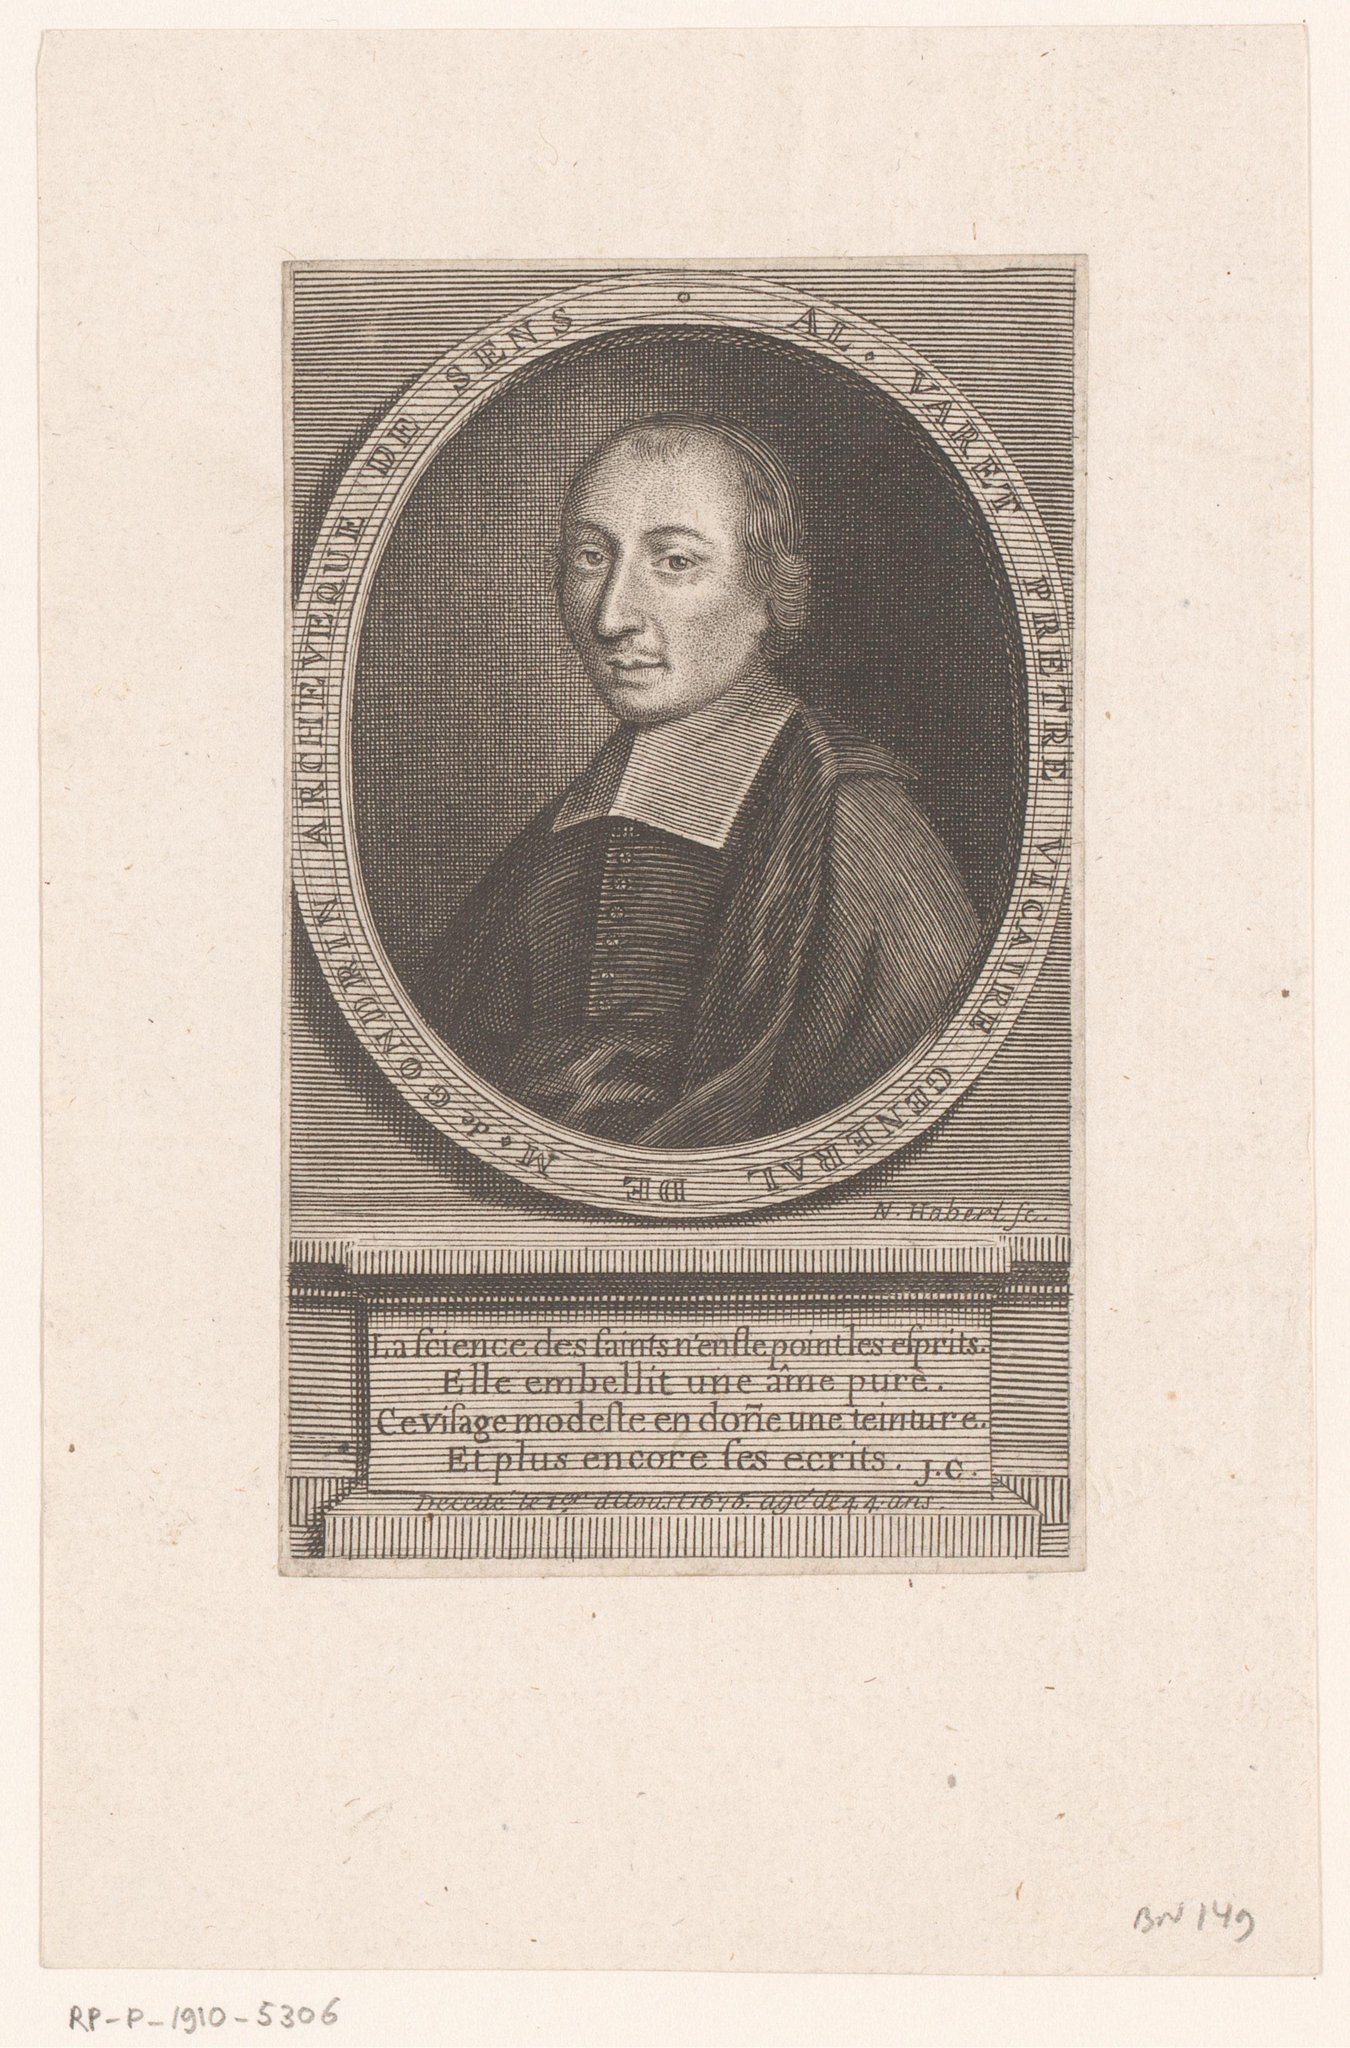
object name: print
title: Portret van Alexandre-Louis Varet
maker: nicolas habert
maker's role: print maker, publisher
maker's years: 1650-1715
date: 1676-1715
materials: paper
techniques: engraving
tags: priest (roman catholic), historical persons, lawyer, attorney at law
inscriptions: collector's mark: Lugt 2228